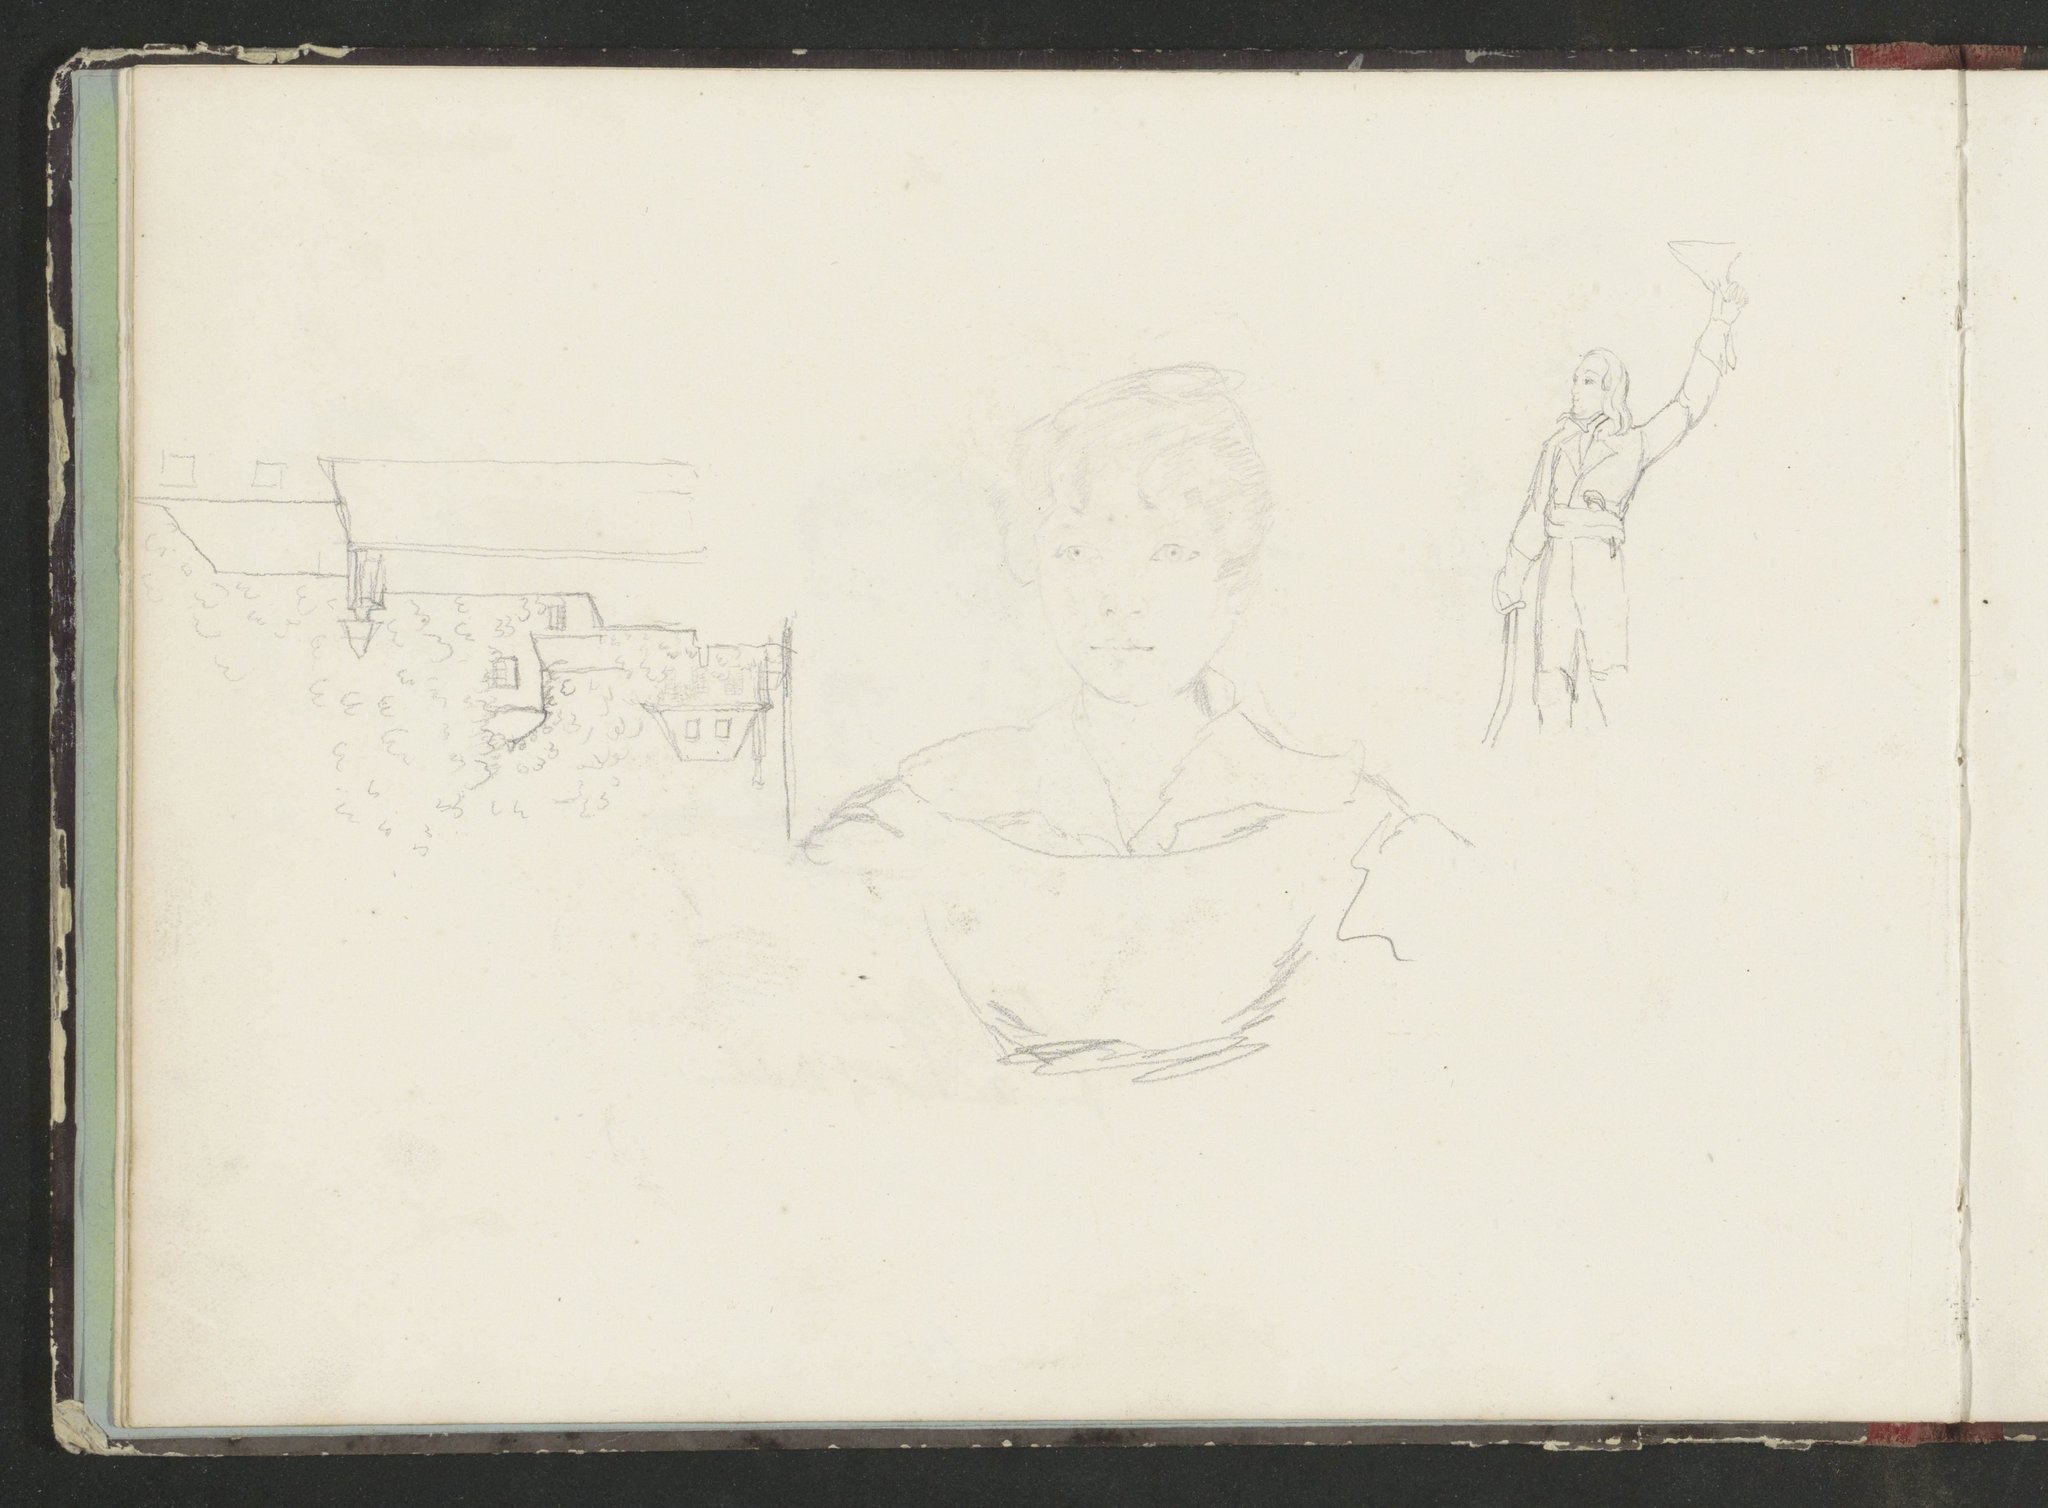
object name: sketchbook leaf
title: Portret van een onbekend meisje, een man met zwaard en daken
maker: Anonymous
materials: paper, pencil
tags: roof (of house or building), hacking and thrusting weapons: sword, anonymous historical person portrayed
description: Blad 4 verso uit een schetsboek met 39 bladen.